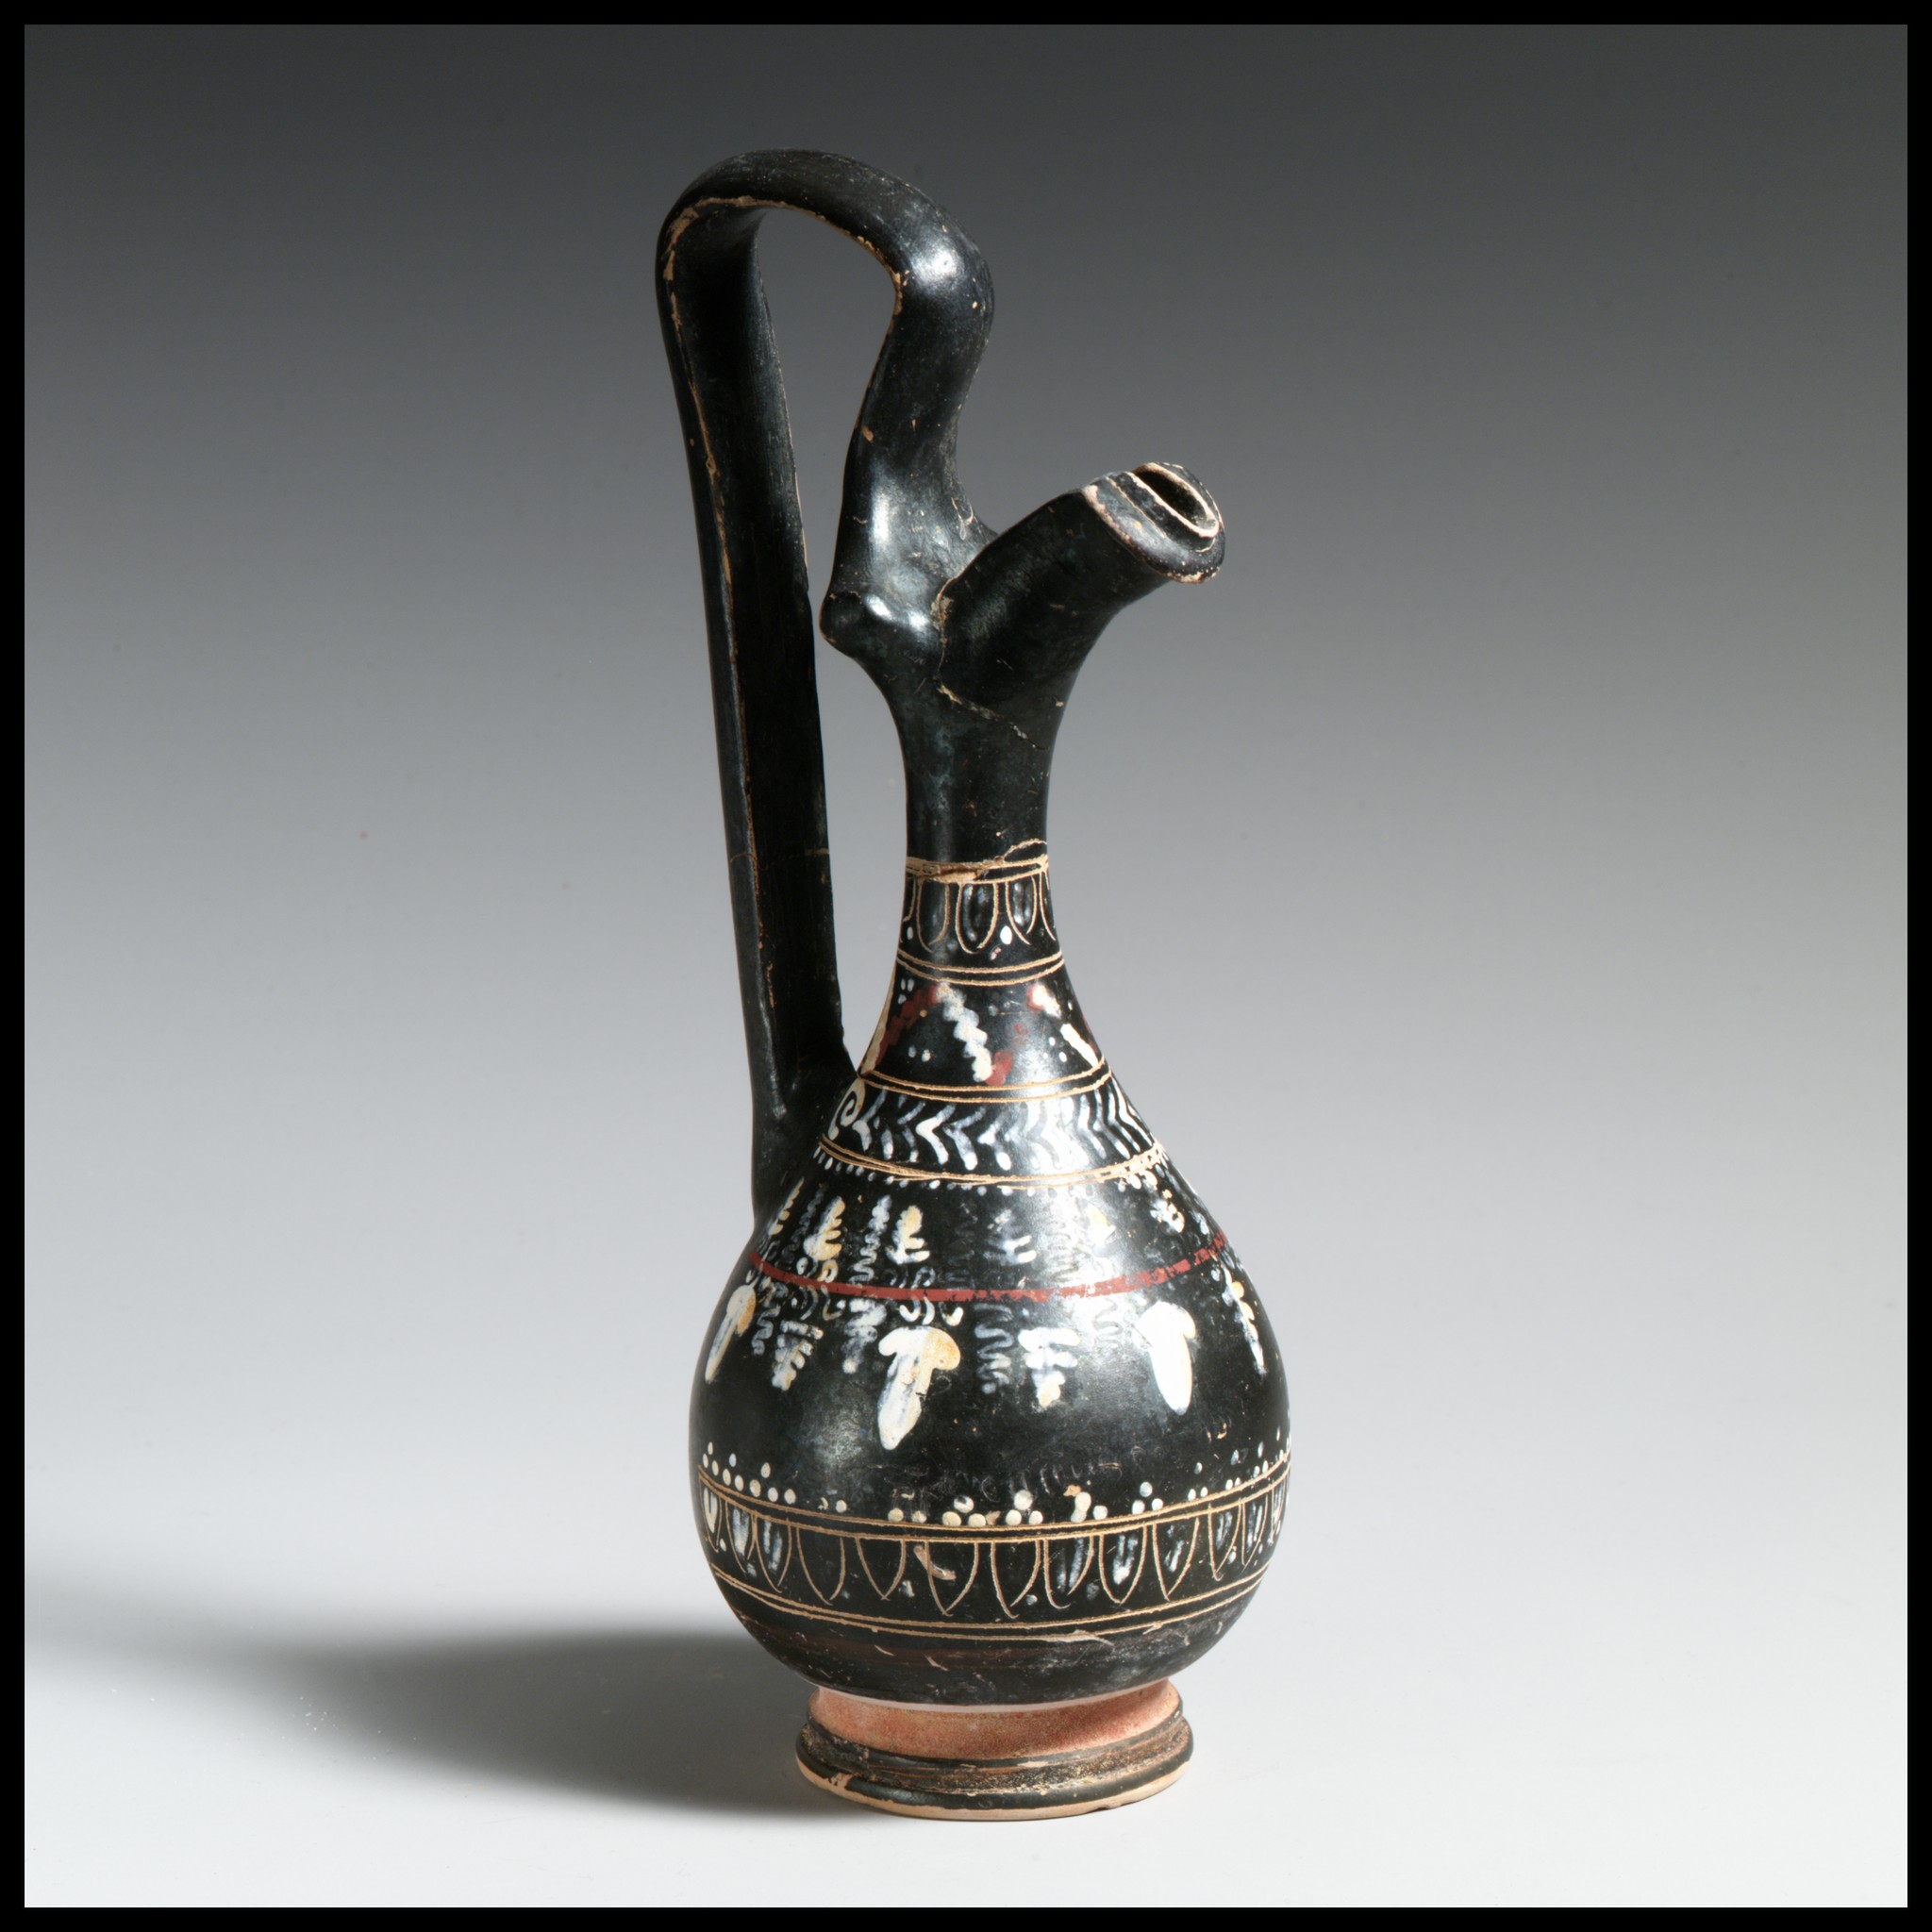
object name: oinochoe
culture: greek, south italian, apulian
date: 350-300 BCE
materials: terracotta